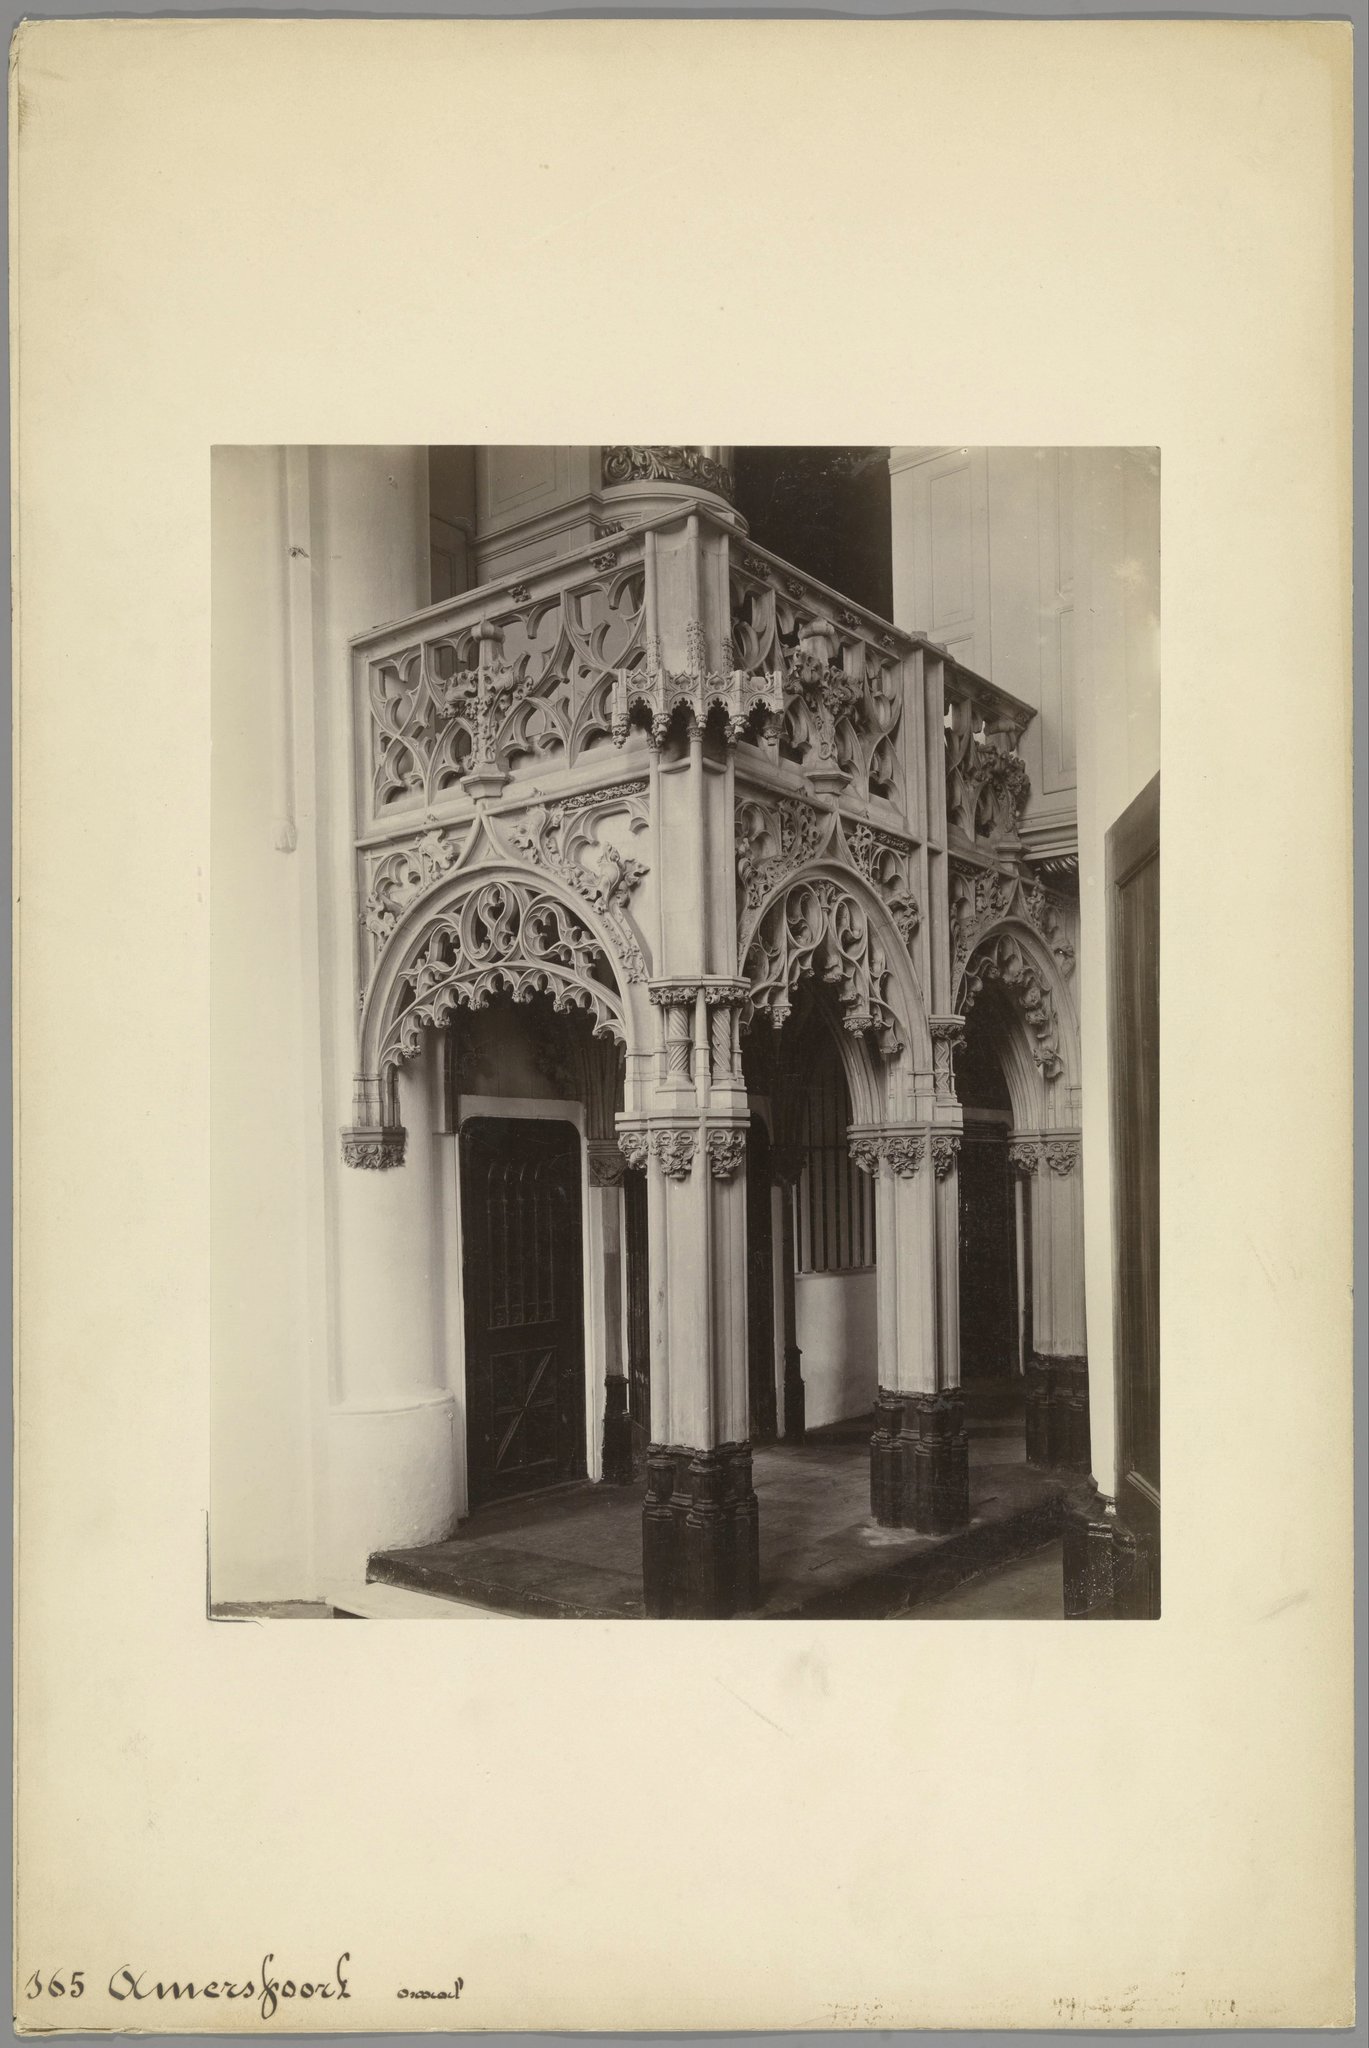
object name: photograph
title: Doksaal van de Sint-Joriskerk te Amersfoort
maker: johannes gerardus kramer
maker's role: fotograaf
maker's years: 1845-1903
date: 1875-1900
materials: cardboard, photographic support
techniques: albumen print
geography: amersfoort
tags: rood-screen, choir-screen; iconostasis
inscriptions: number: ‘365’, collector's mark: Lugt 3937, name: ‘J.G. Kramer Groningen’